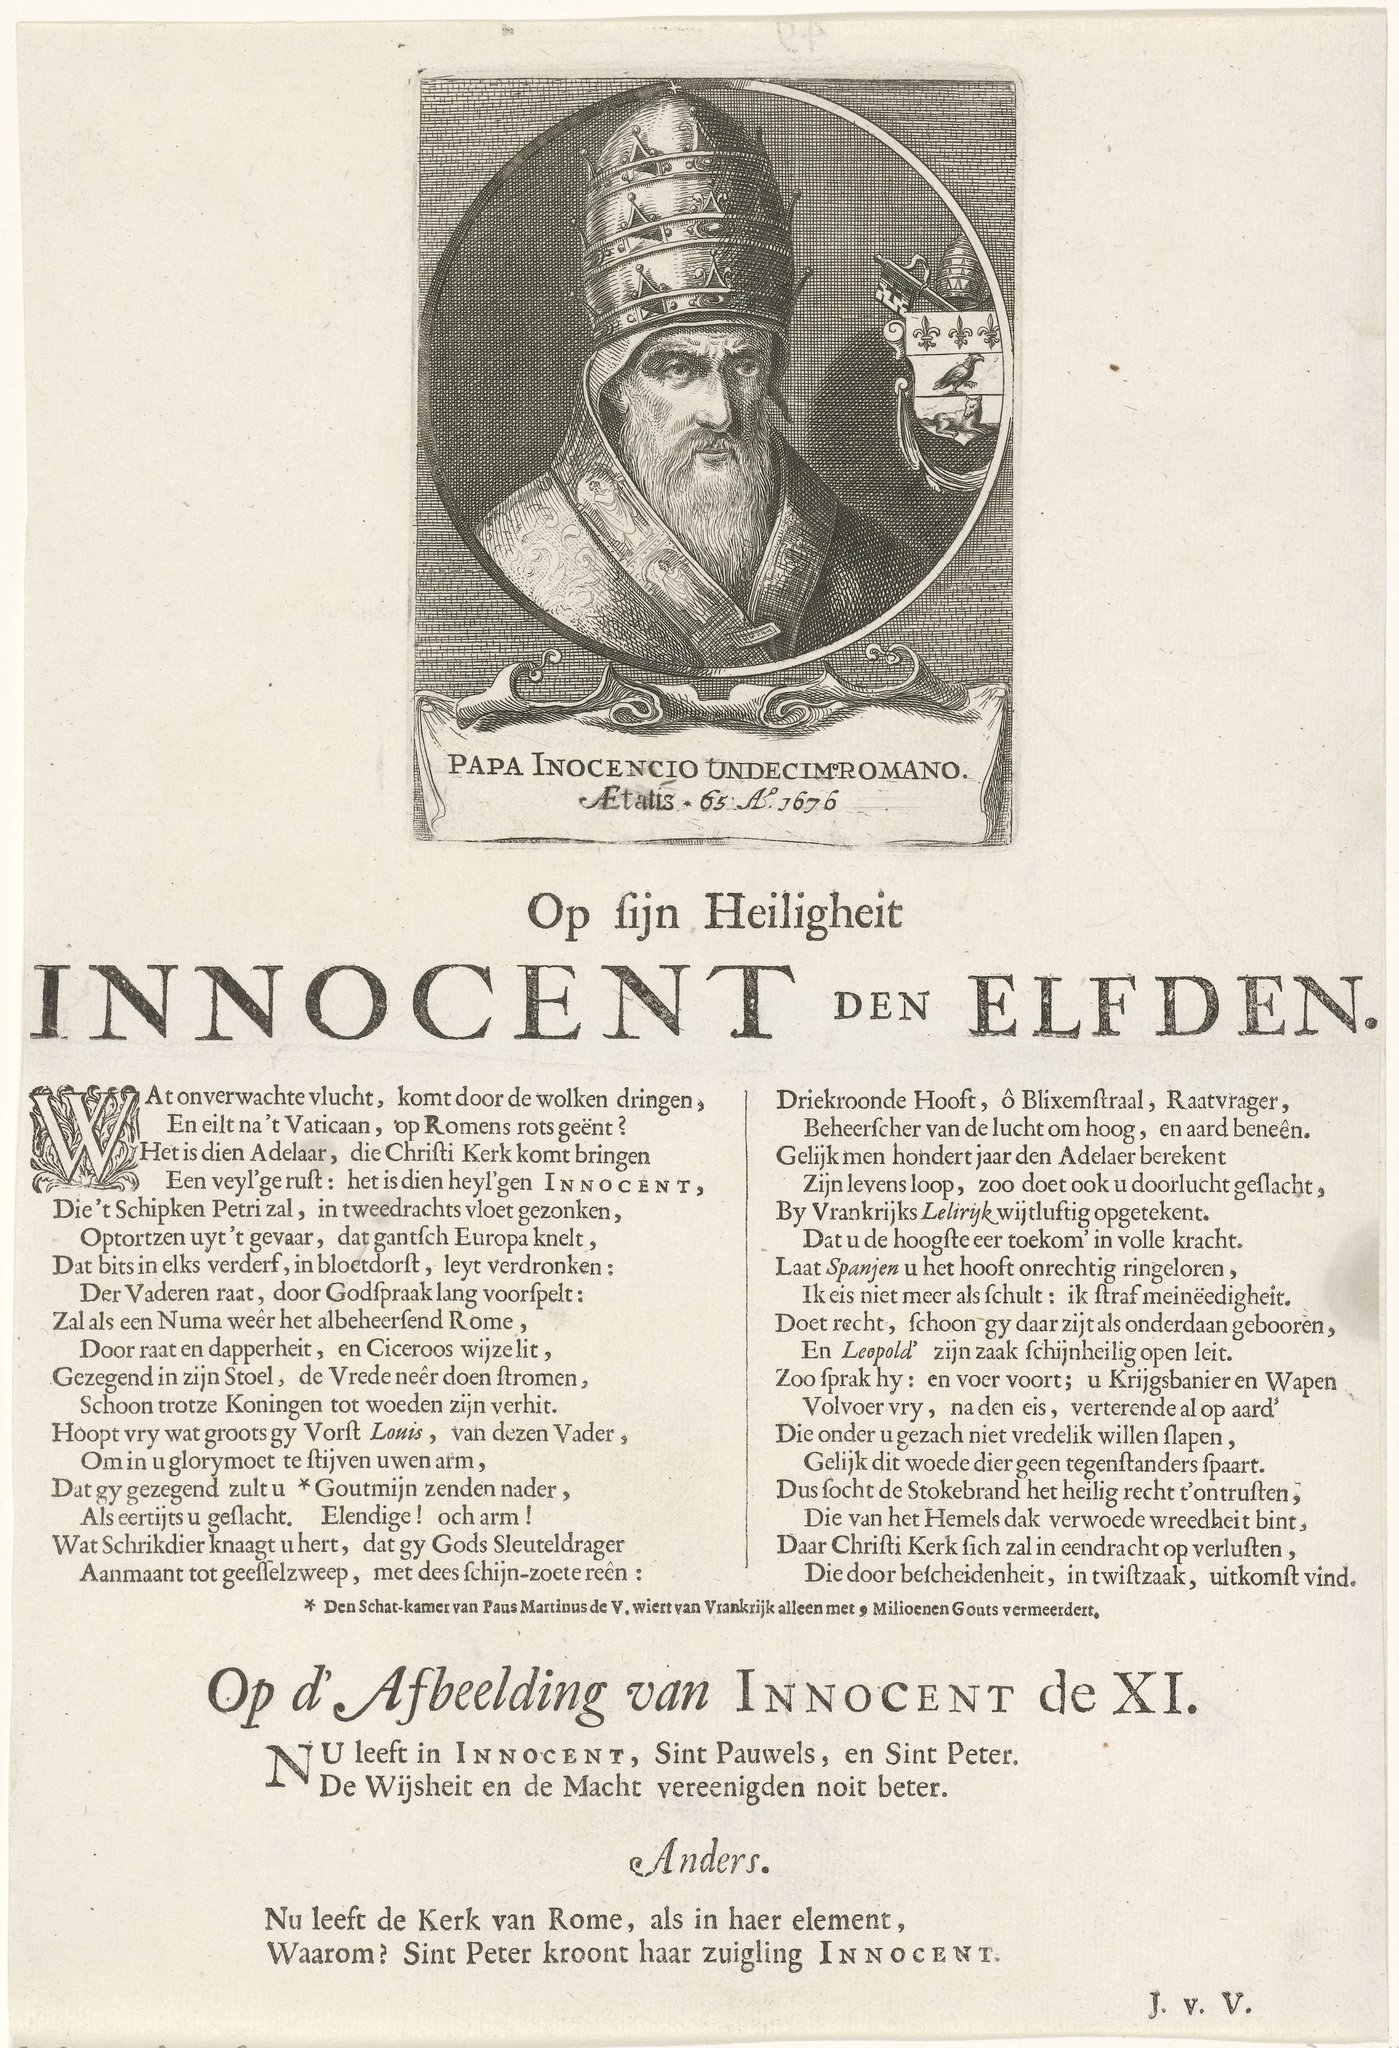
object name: print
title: Portret van paus Innocentius XI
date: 1676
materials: paper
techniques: engraving, etching, letterpress printing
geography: amsterdam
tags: clergyman, innocentius xi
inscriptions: collector's mark: Lugt 2228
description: Portret van paus Innocentius XI gehuld in het pauselijk gewaad en het hoofd getooid met de pauselijke tiara. Rechts zijn pauselijke wapen. Buste naar rechts in een cirkelvormige lijst. Onderaan op een cartouche zijn titel en leeftijd in het Latijn. Onderaan twee kolommen tekst in boekdruk in het Nederlands en een gedicht op de paus.